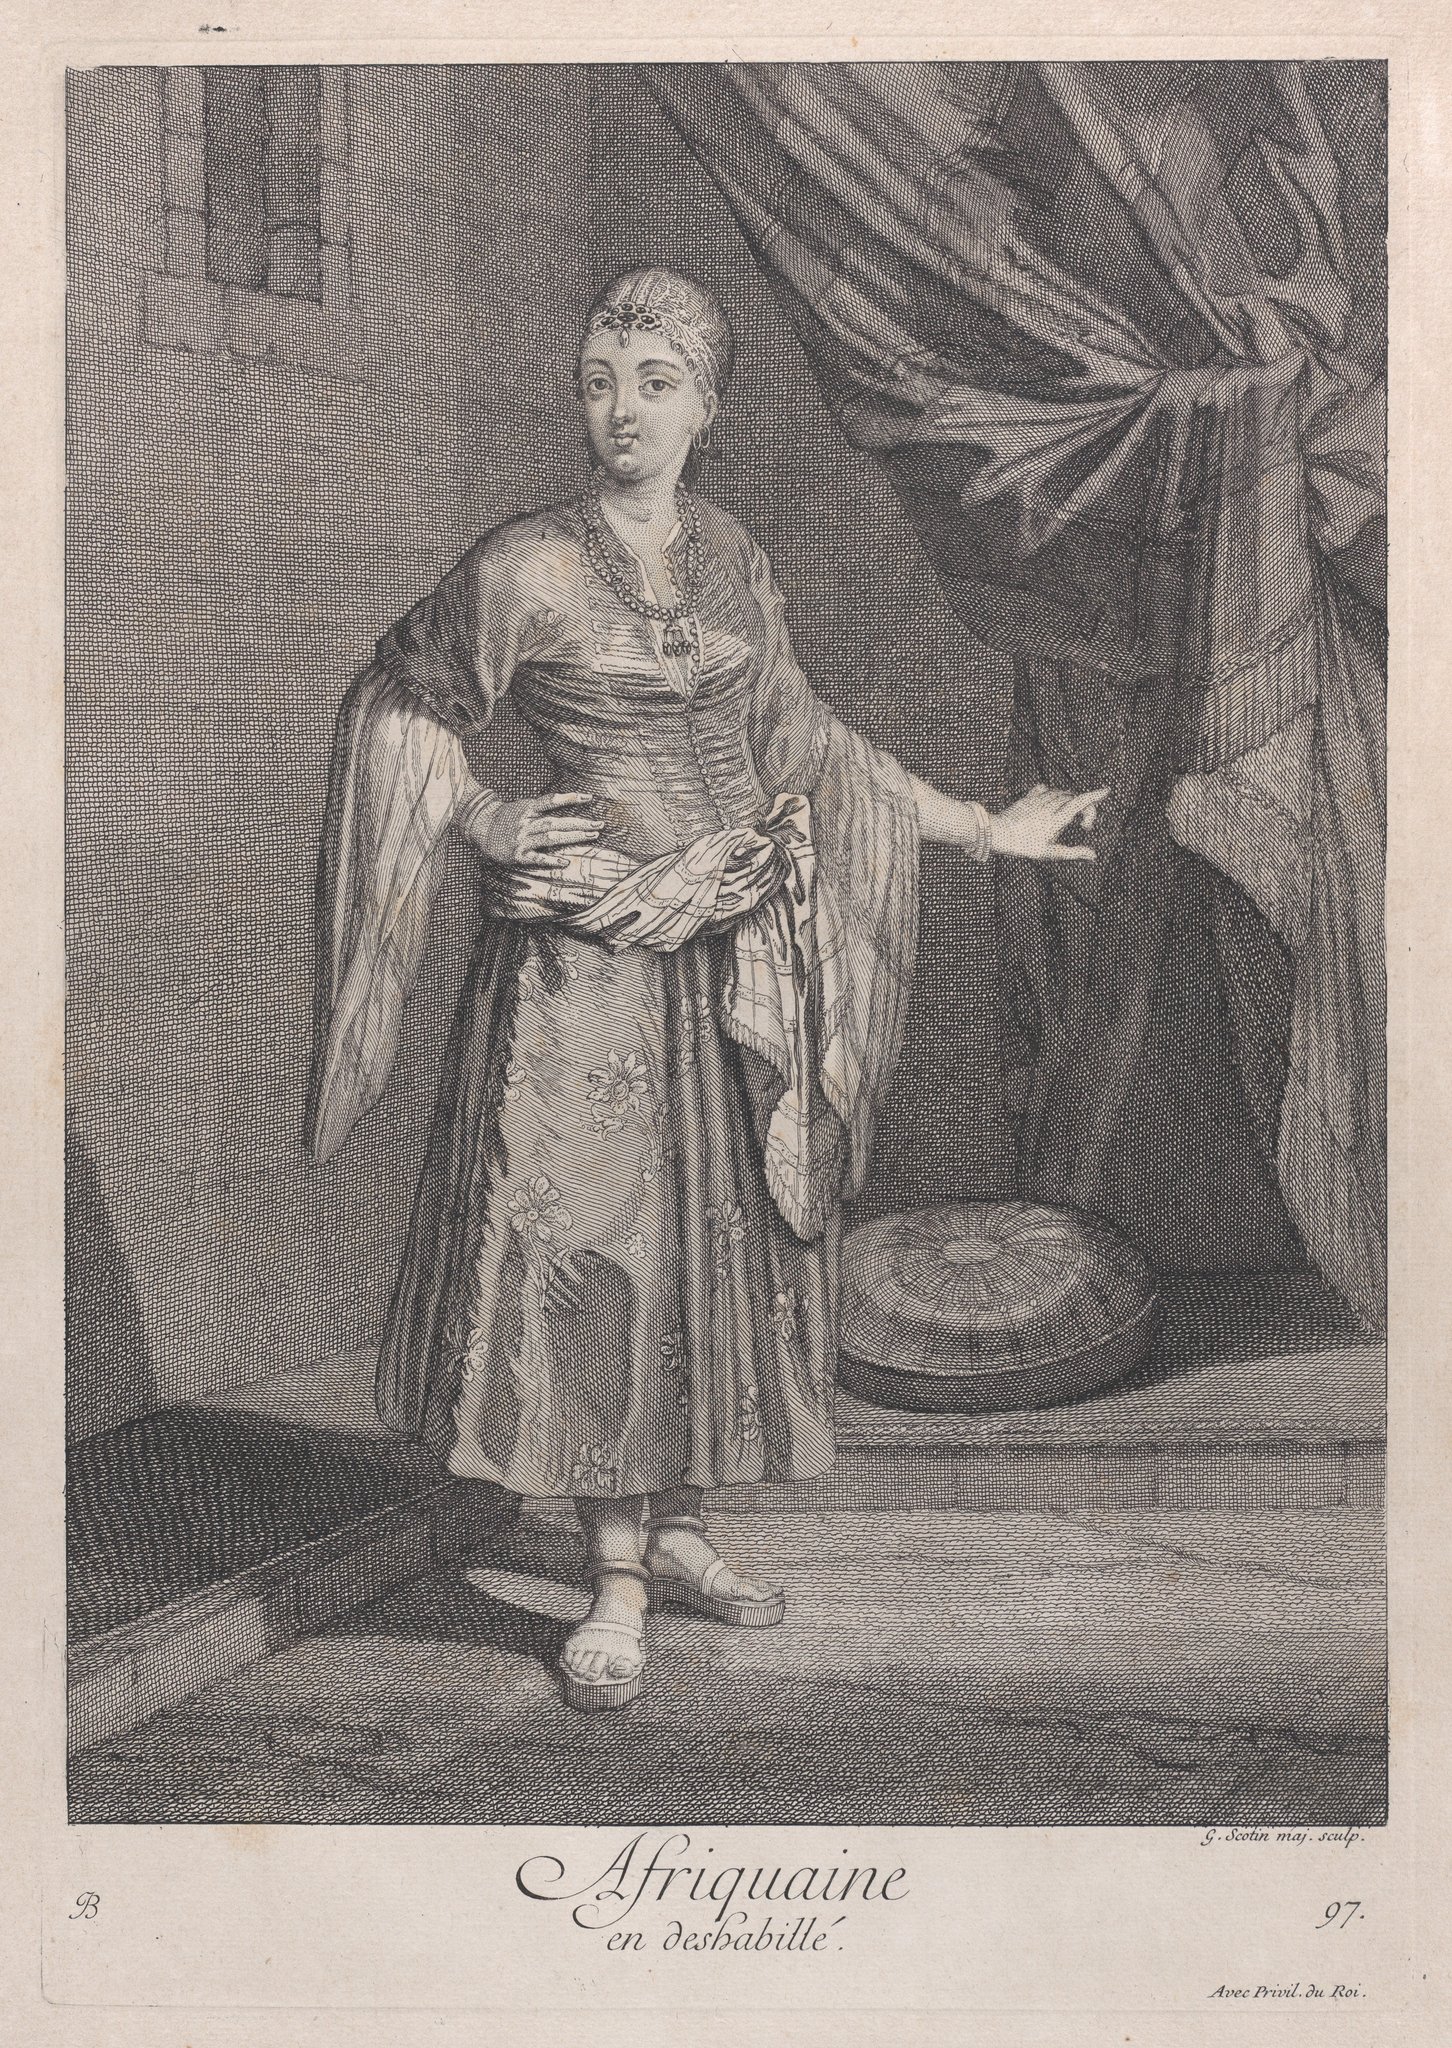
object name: print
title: Afriquaine, en deshabillé, plate 97 from "Recueil de cent estampes représentent differentes nations du Levant"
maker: jean baptiste vanmour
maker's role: artist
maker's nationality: french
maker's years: 1671-1737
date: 1714-1715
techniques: engraving, etching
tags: women